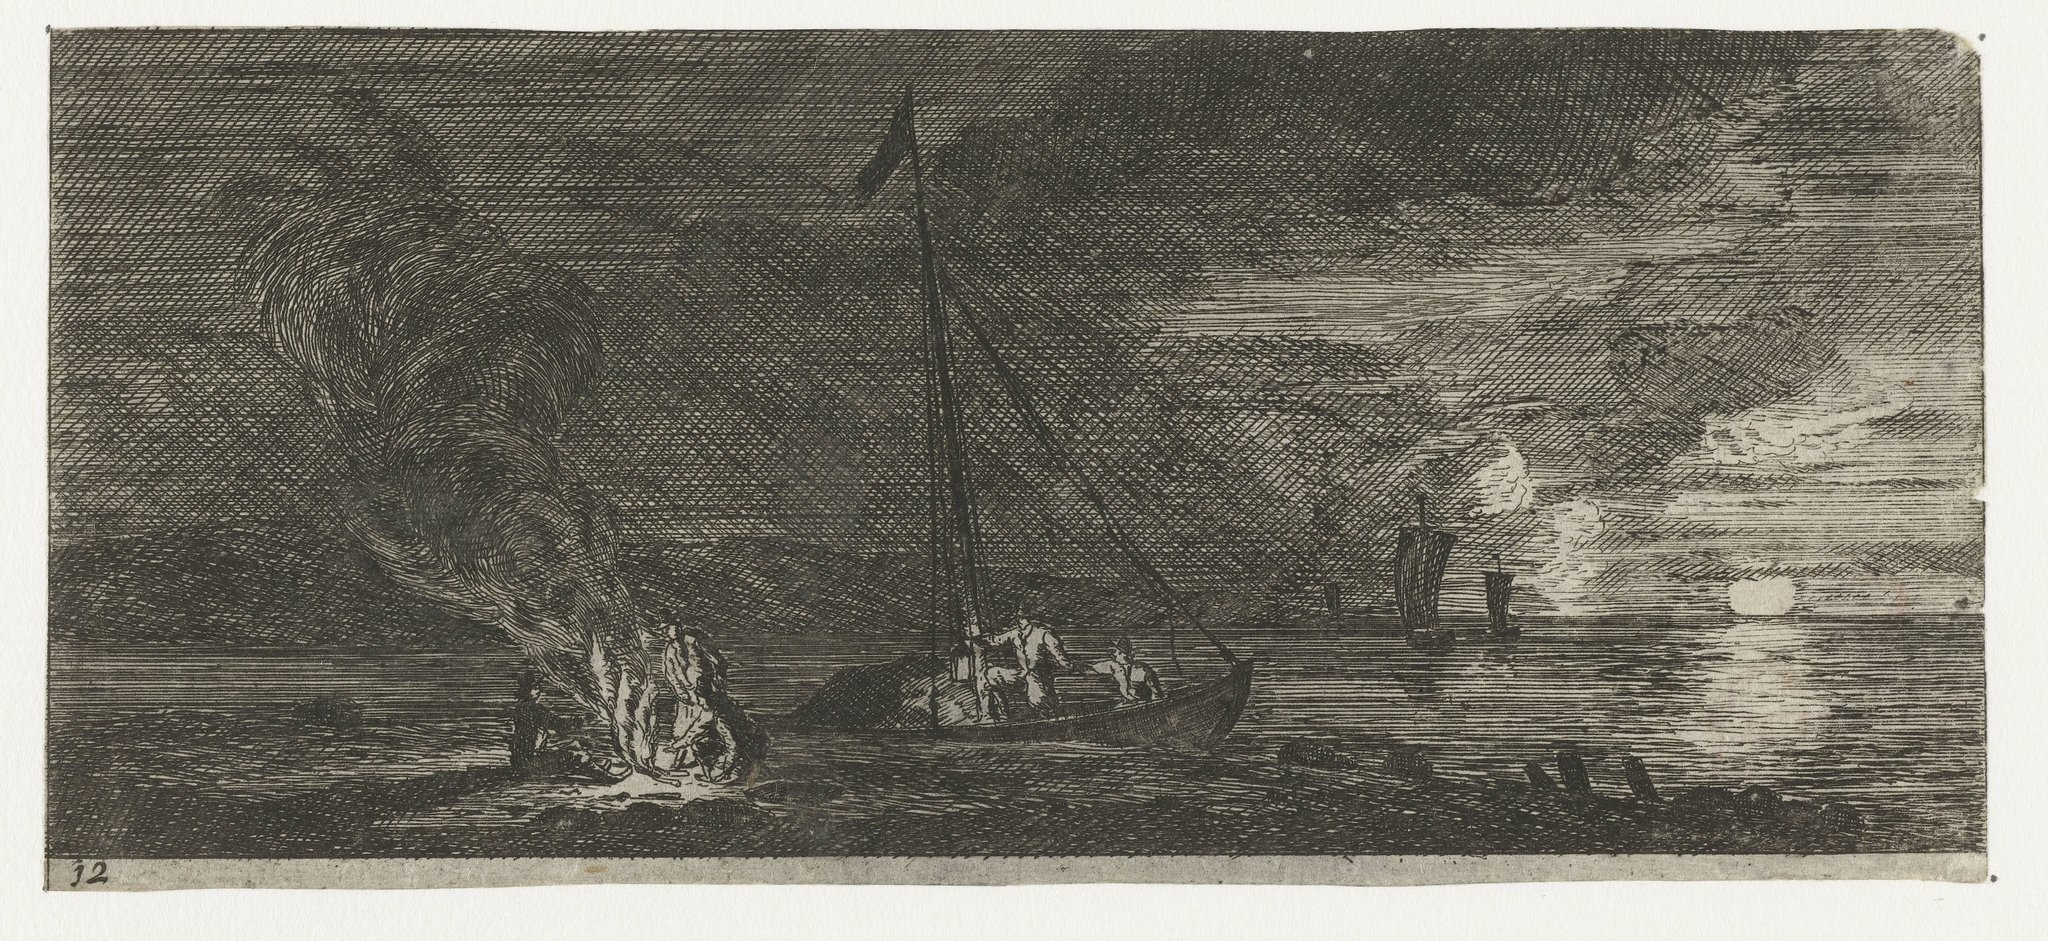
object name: print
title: Divers Embarquements et autre Faicts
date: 1651-1652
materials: paper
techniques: engraving, etching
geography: amsterdam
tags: sailing-ship, sailing-boat, open fire (in general), night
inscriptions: collector's mark: Lugt 12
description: Drie figuren rond een vuur op de kust, twee figuren met een lantaarn in een boot en drie zeilschepen op zee bij een ondergaande zon.